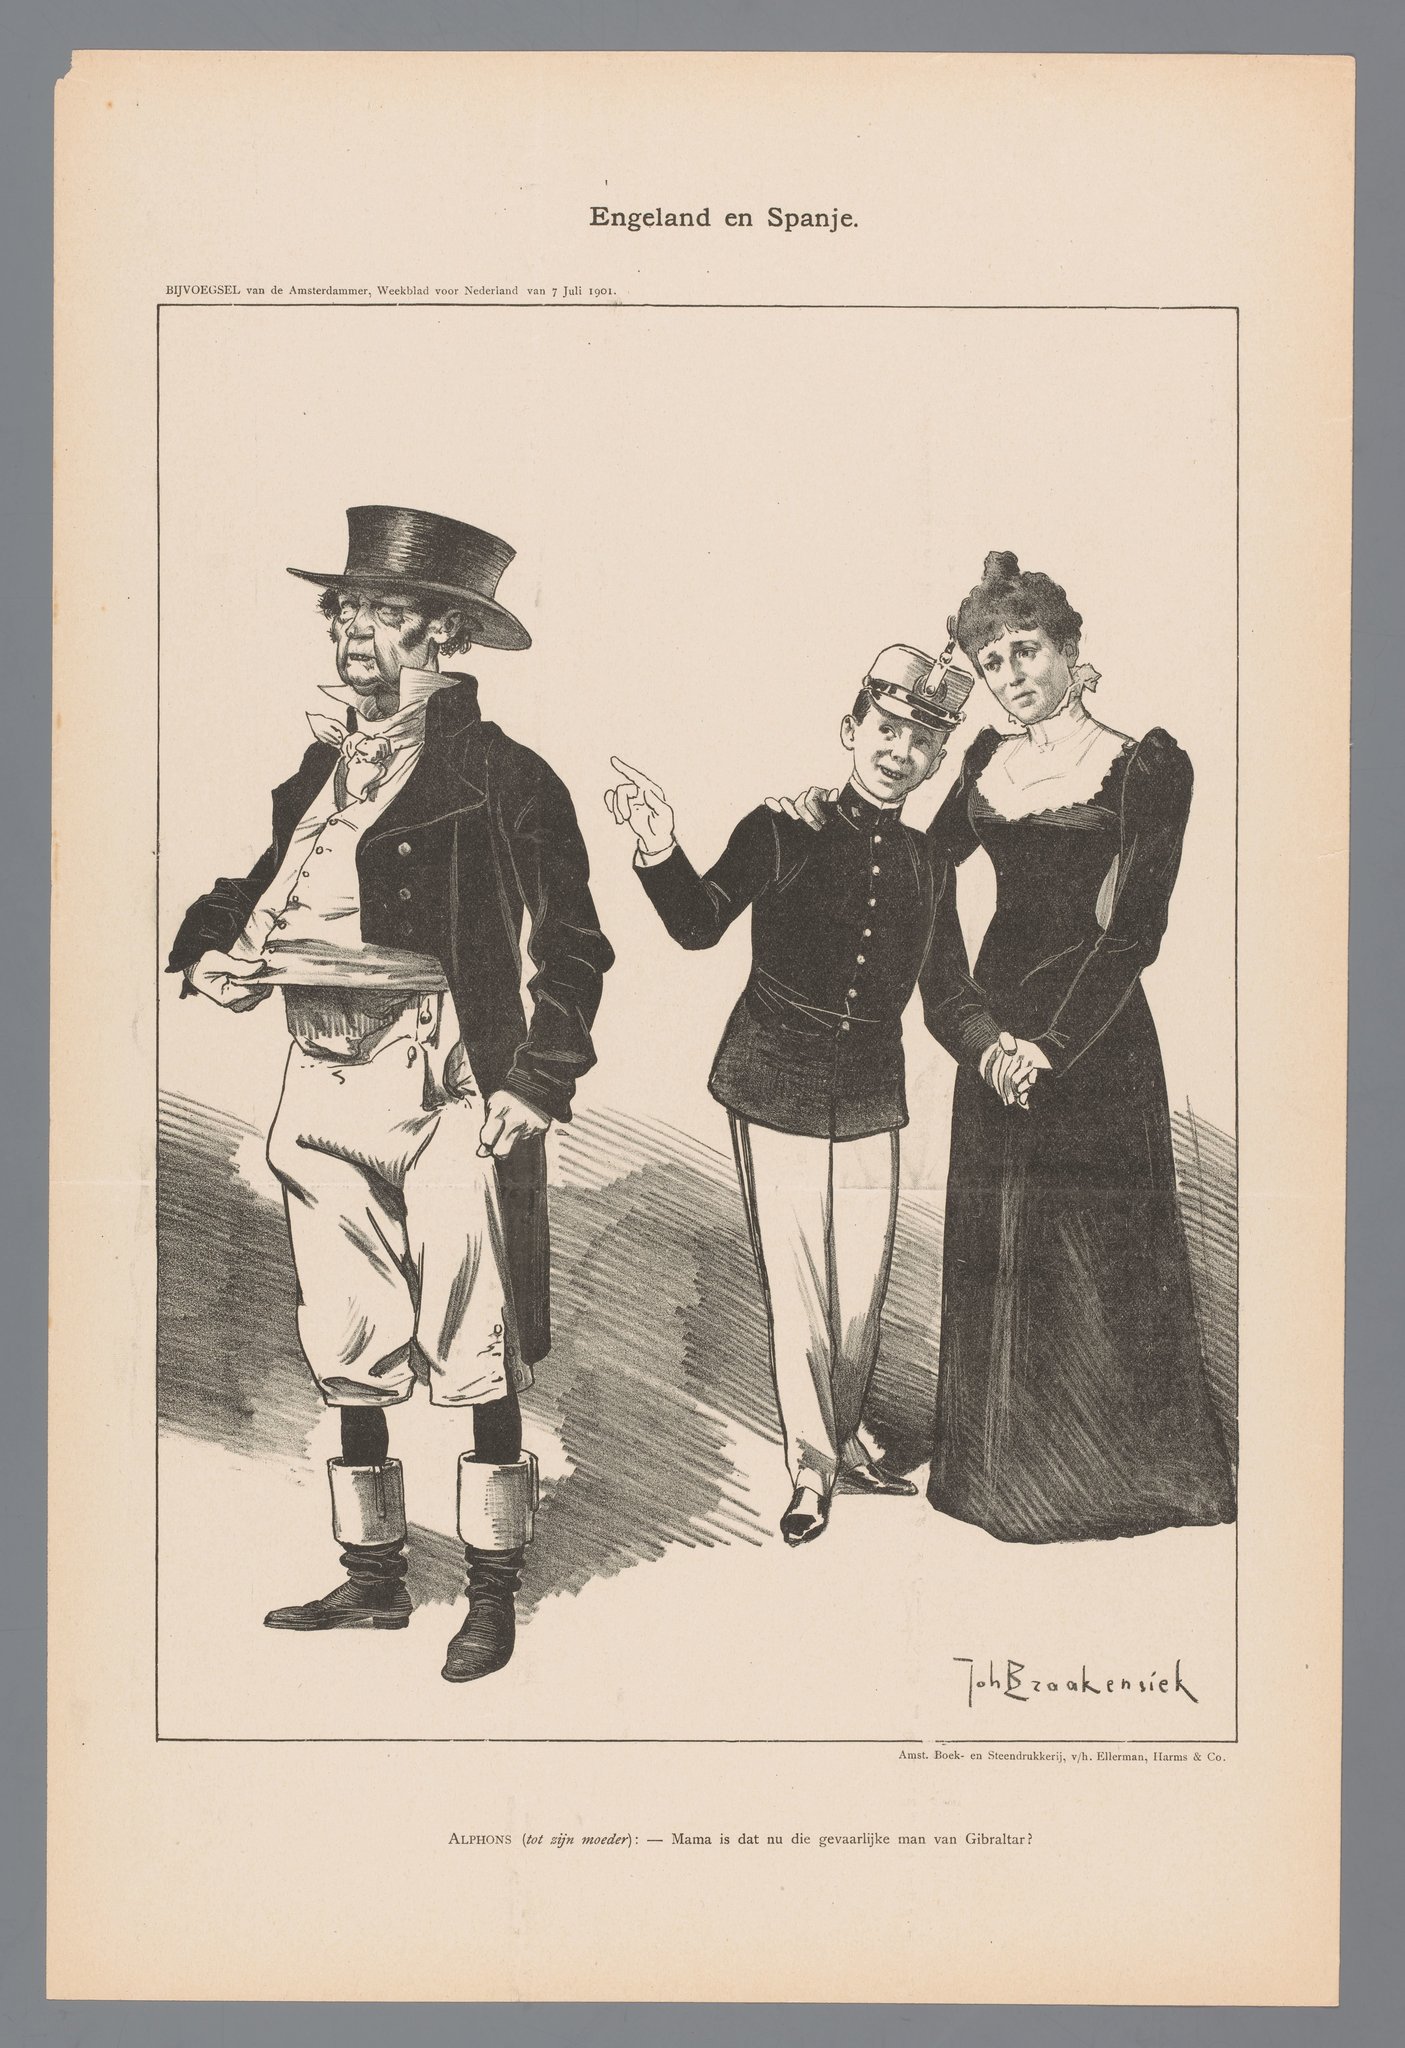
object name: cartoon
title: Engeland en Spanje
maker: johan braakensiek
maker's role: draughtsman, print maker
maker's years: 1858-1940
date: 1901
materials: paper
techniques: lithograph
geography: amsterdam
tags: vienna, maria christina van oostenrijk (1742-1798), ruler, sovereign, personifications of countries, nations, states, districts, etc. (+ nation; national), political caricatures and satires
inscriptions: date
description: Prent uit het bijvoegsel van: De Amsterdammer. Weekblad voor Nederland, 7 juli 1901.